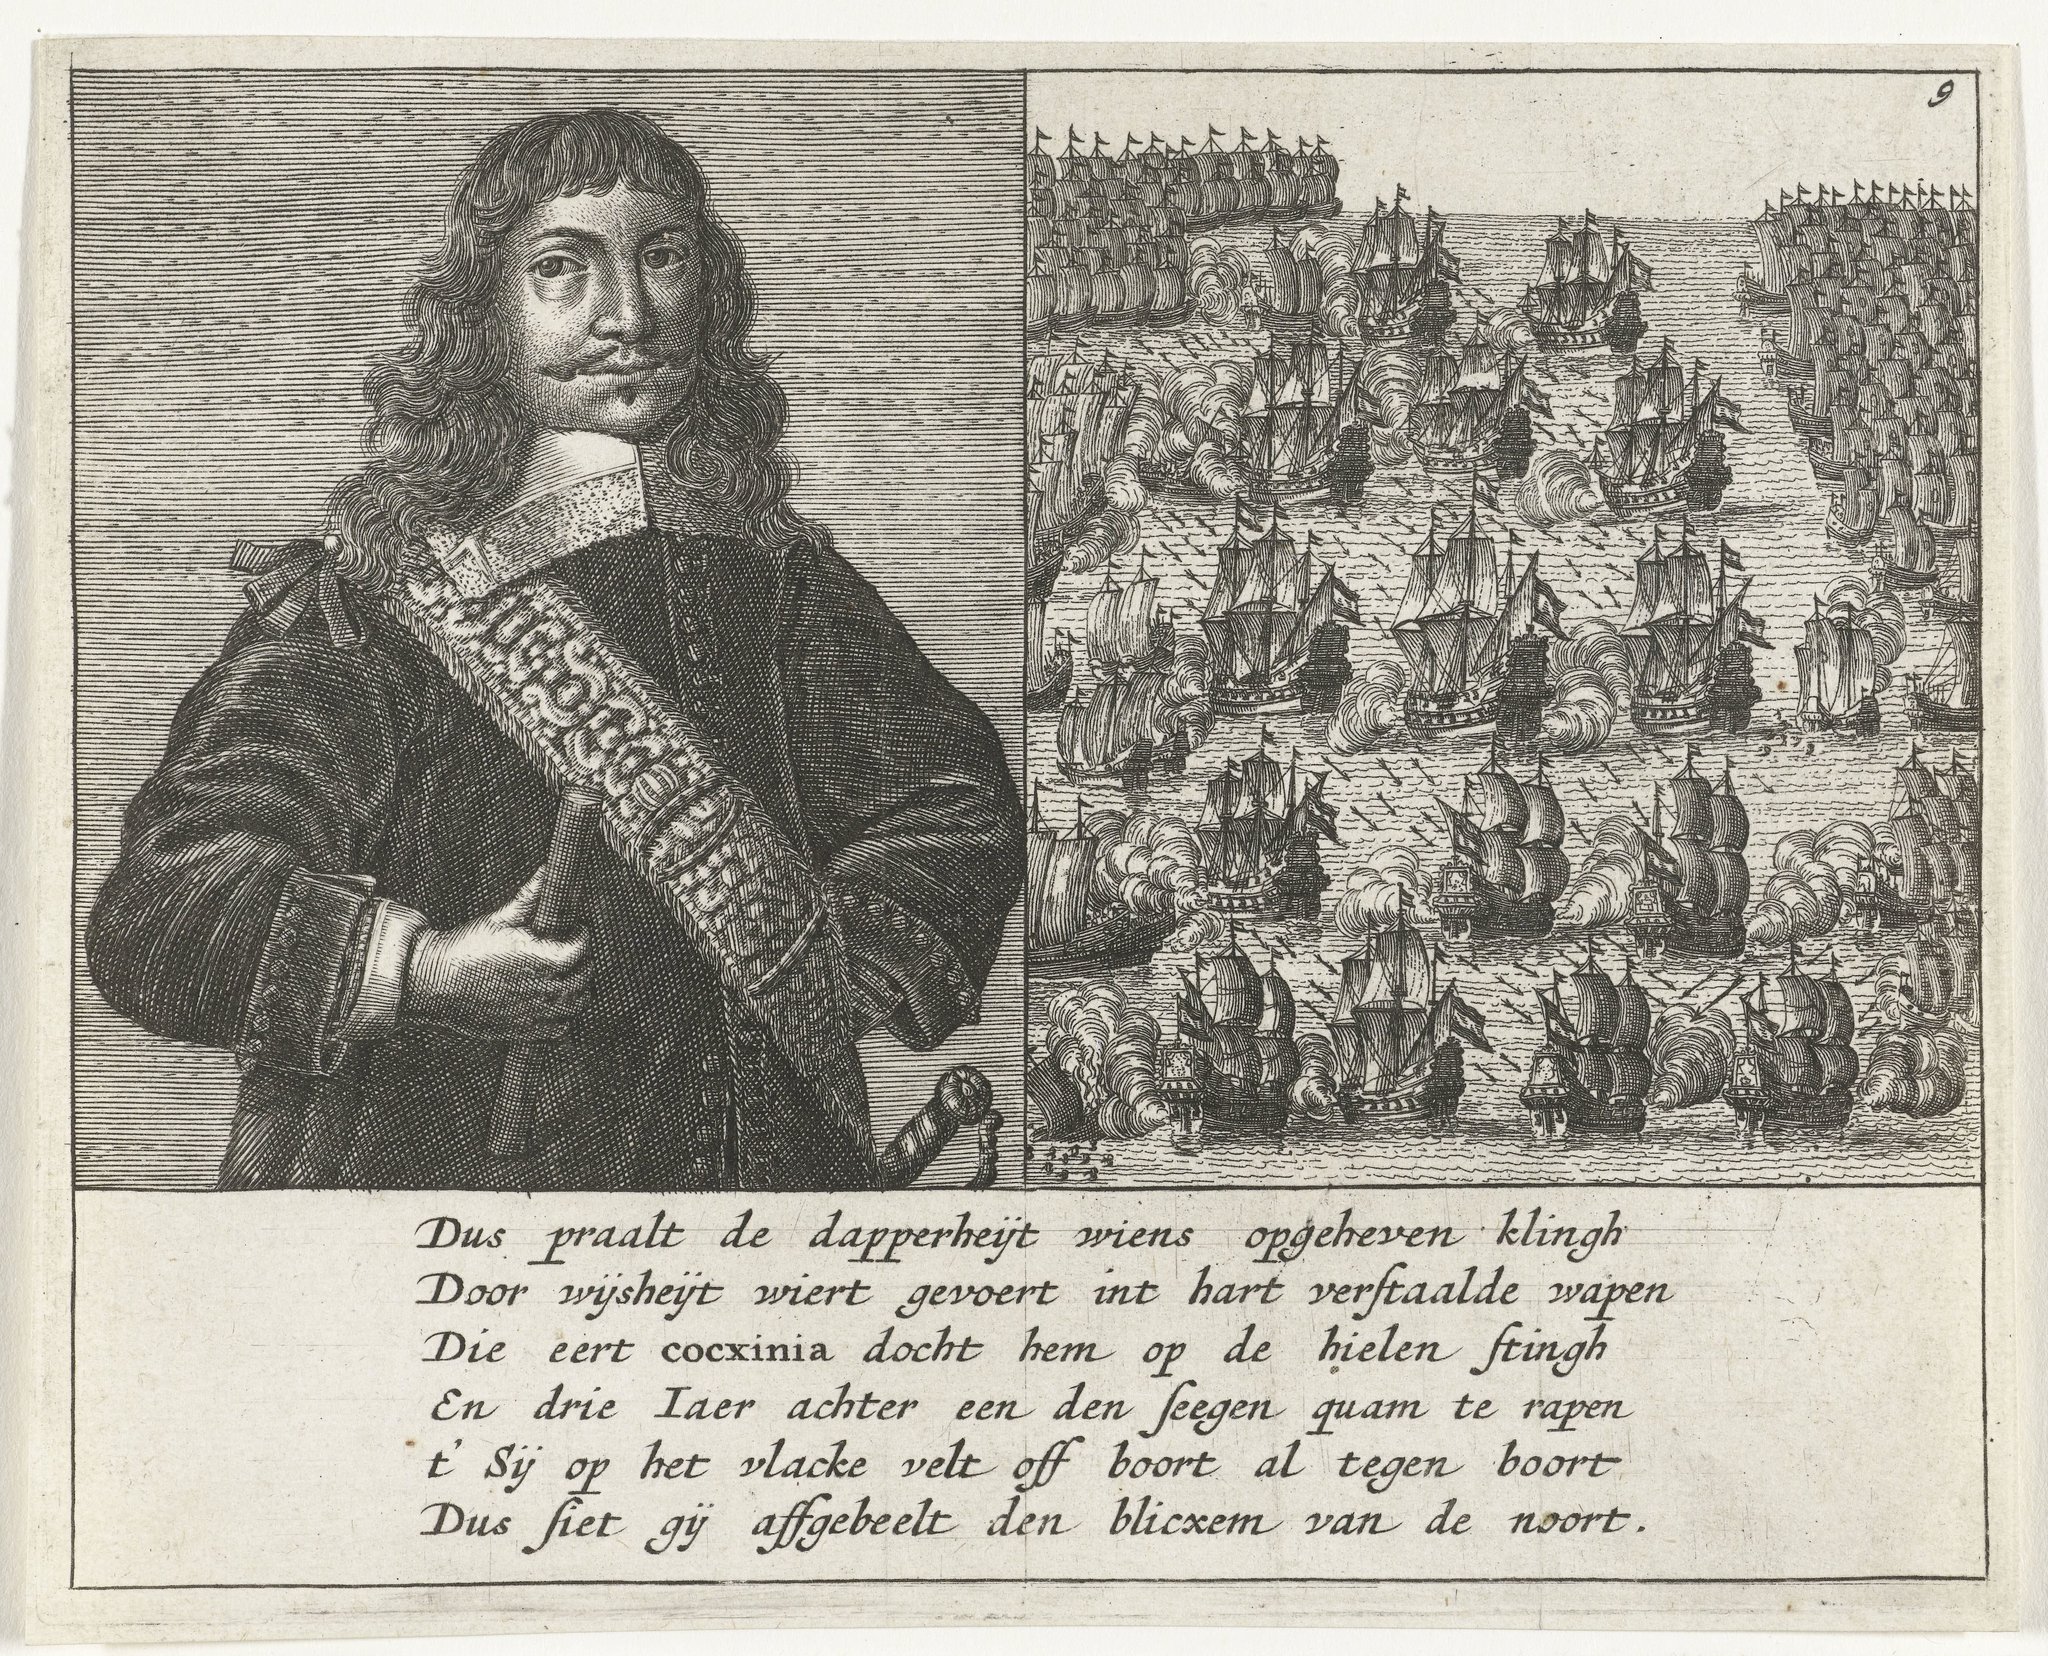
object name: print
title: Portrait of Balthasar Bort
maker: Anonymous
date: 1670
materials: paper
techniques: engraving, etching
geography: northern netherlands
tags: japan, battle (+ naval force)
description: Portret van Balthasar Bort en een zeeslag. In verband met de expedities van de VOC van 1662-1665 onder leiding van Balthasar Bort tegen de Chinese krijgsheer Coxinga. Met een vers van 6 regels. Gemerkt rechtsboven: 9.